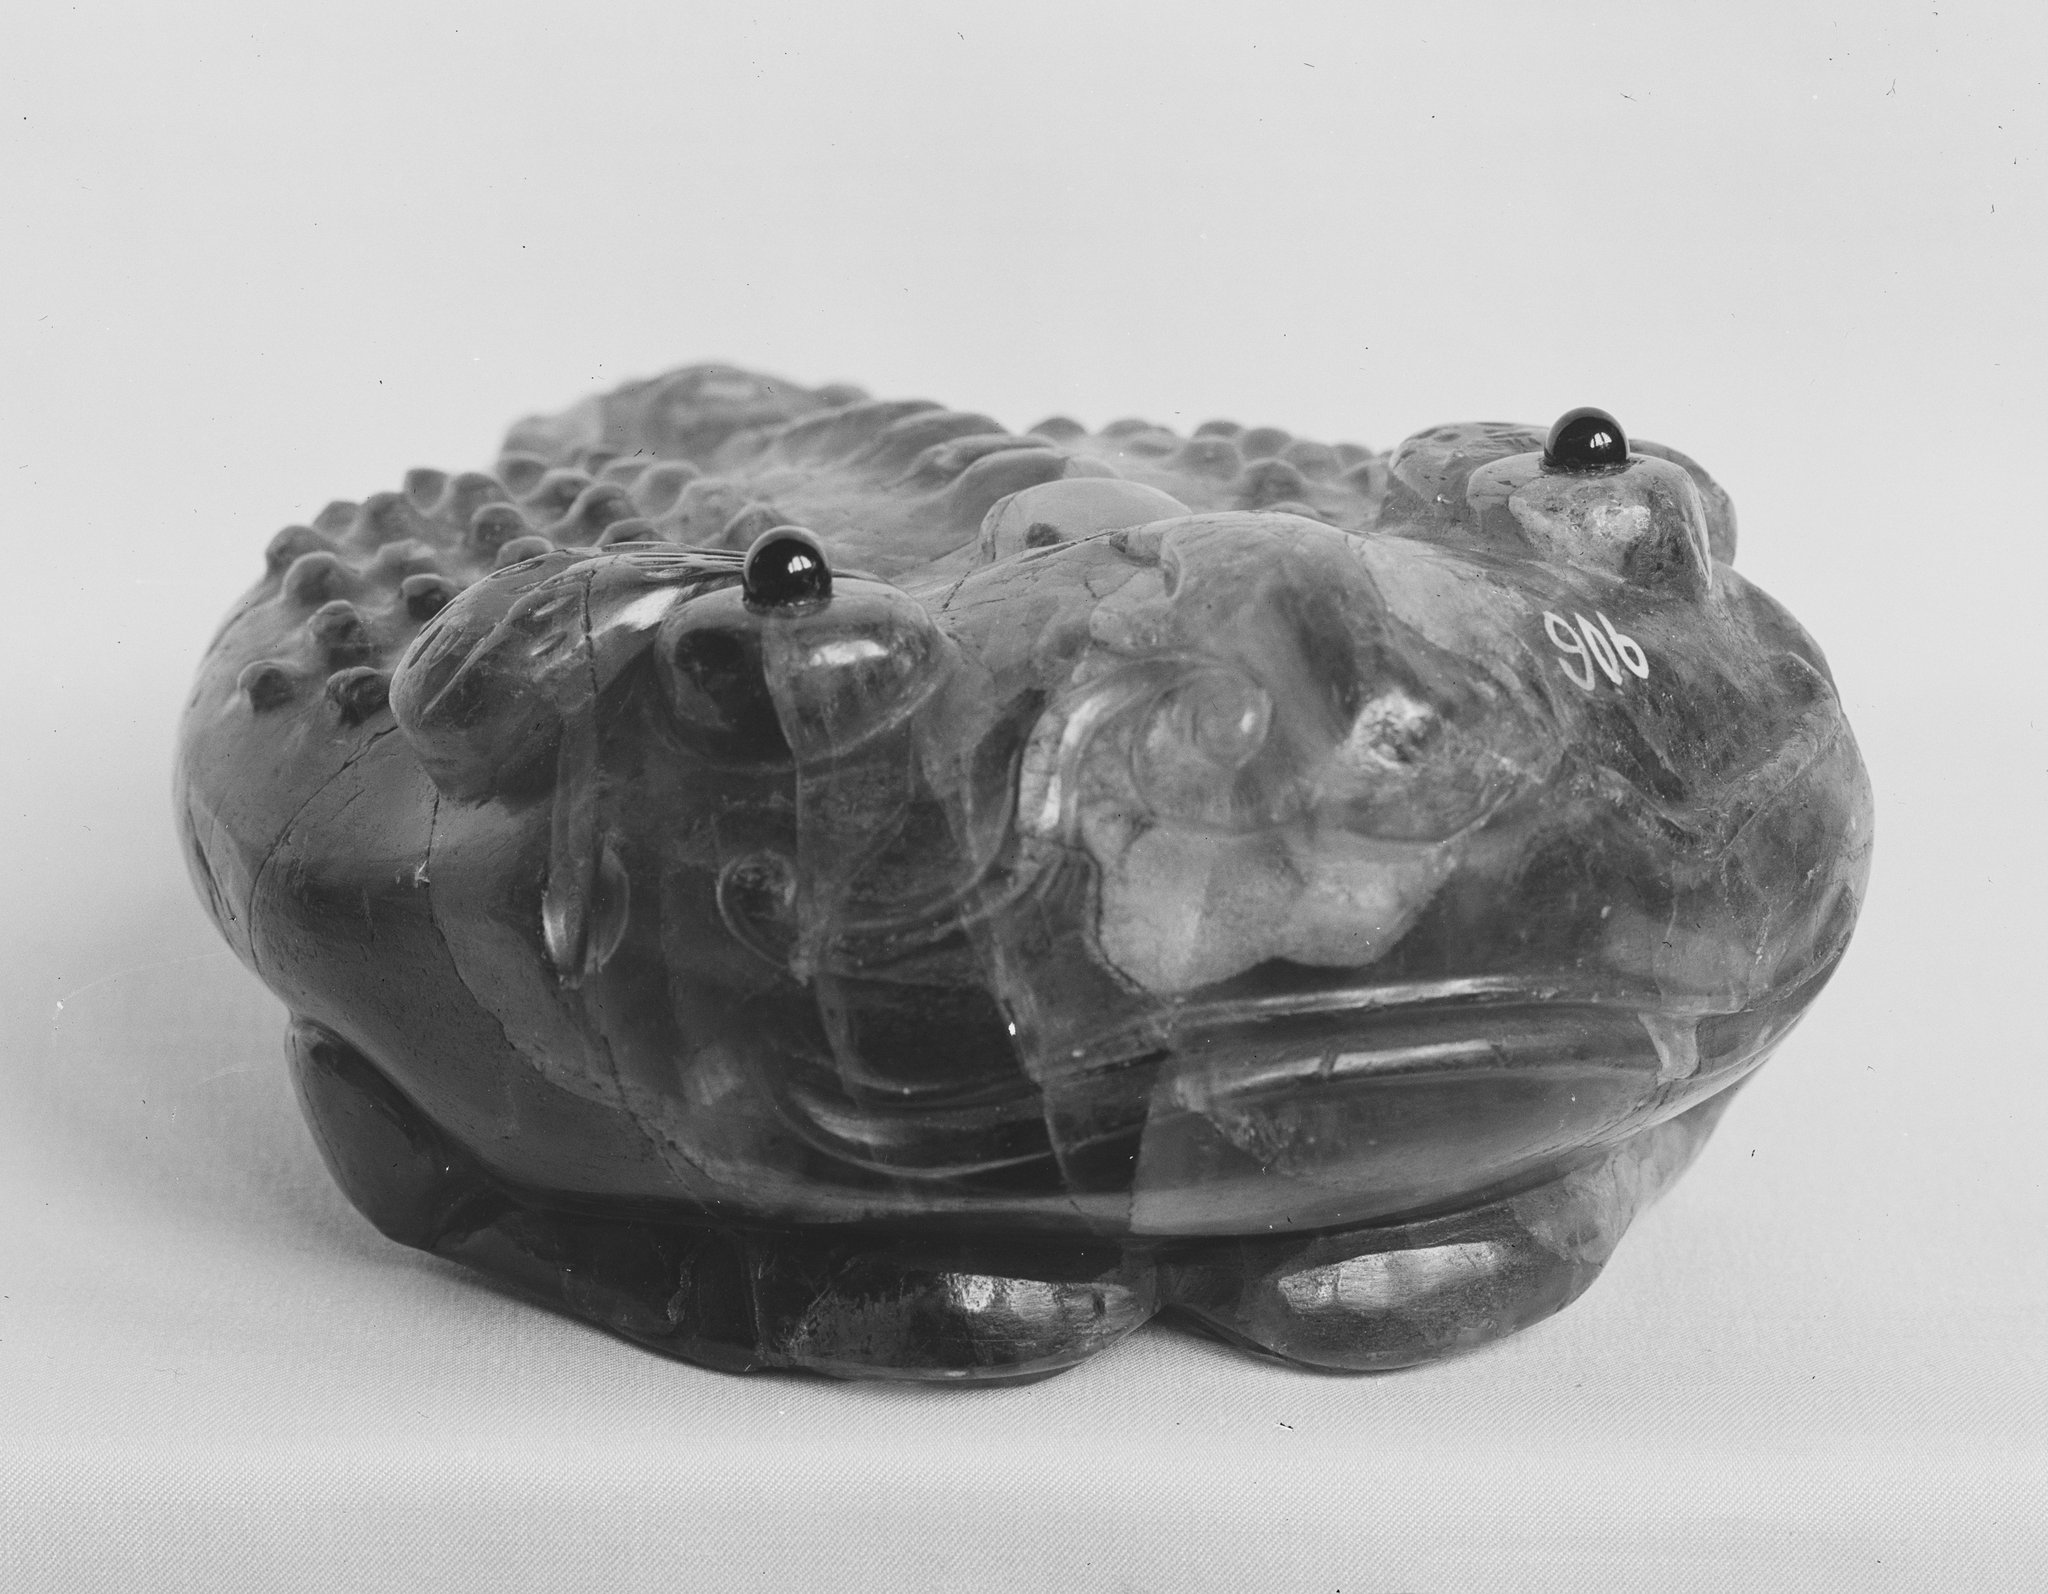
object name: figure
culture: chinese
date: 1701-1800